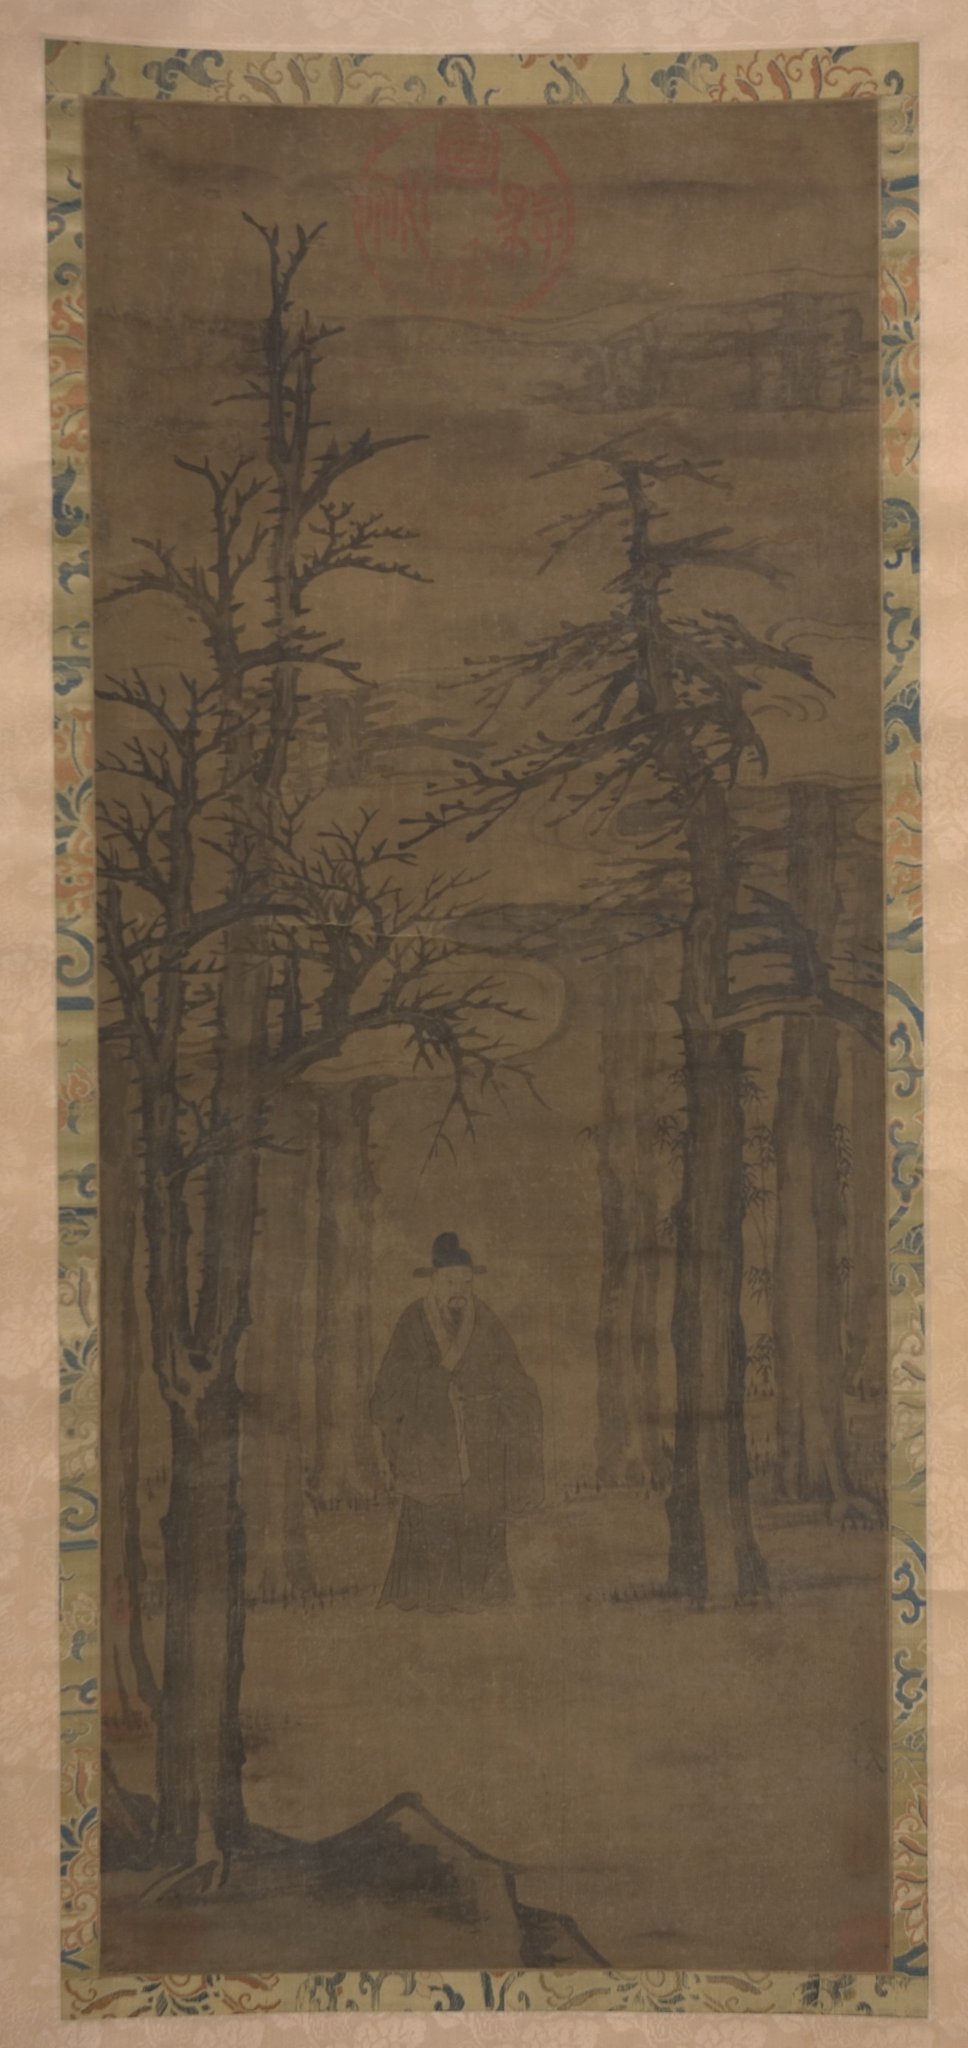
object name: hanging scroll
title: Meditations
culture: chinese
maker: unidentified artist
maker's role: artist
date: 1644-1911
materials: ink, silk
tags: men,trees